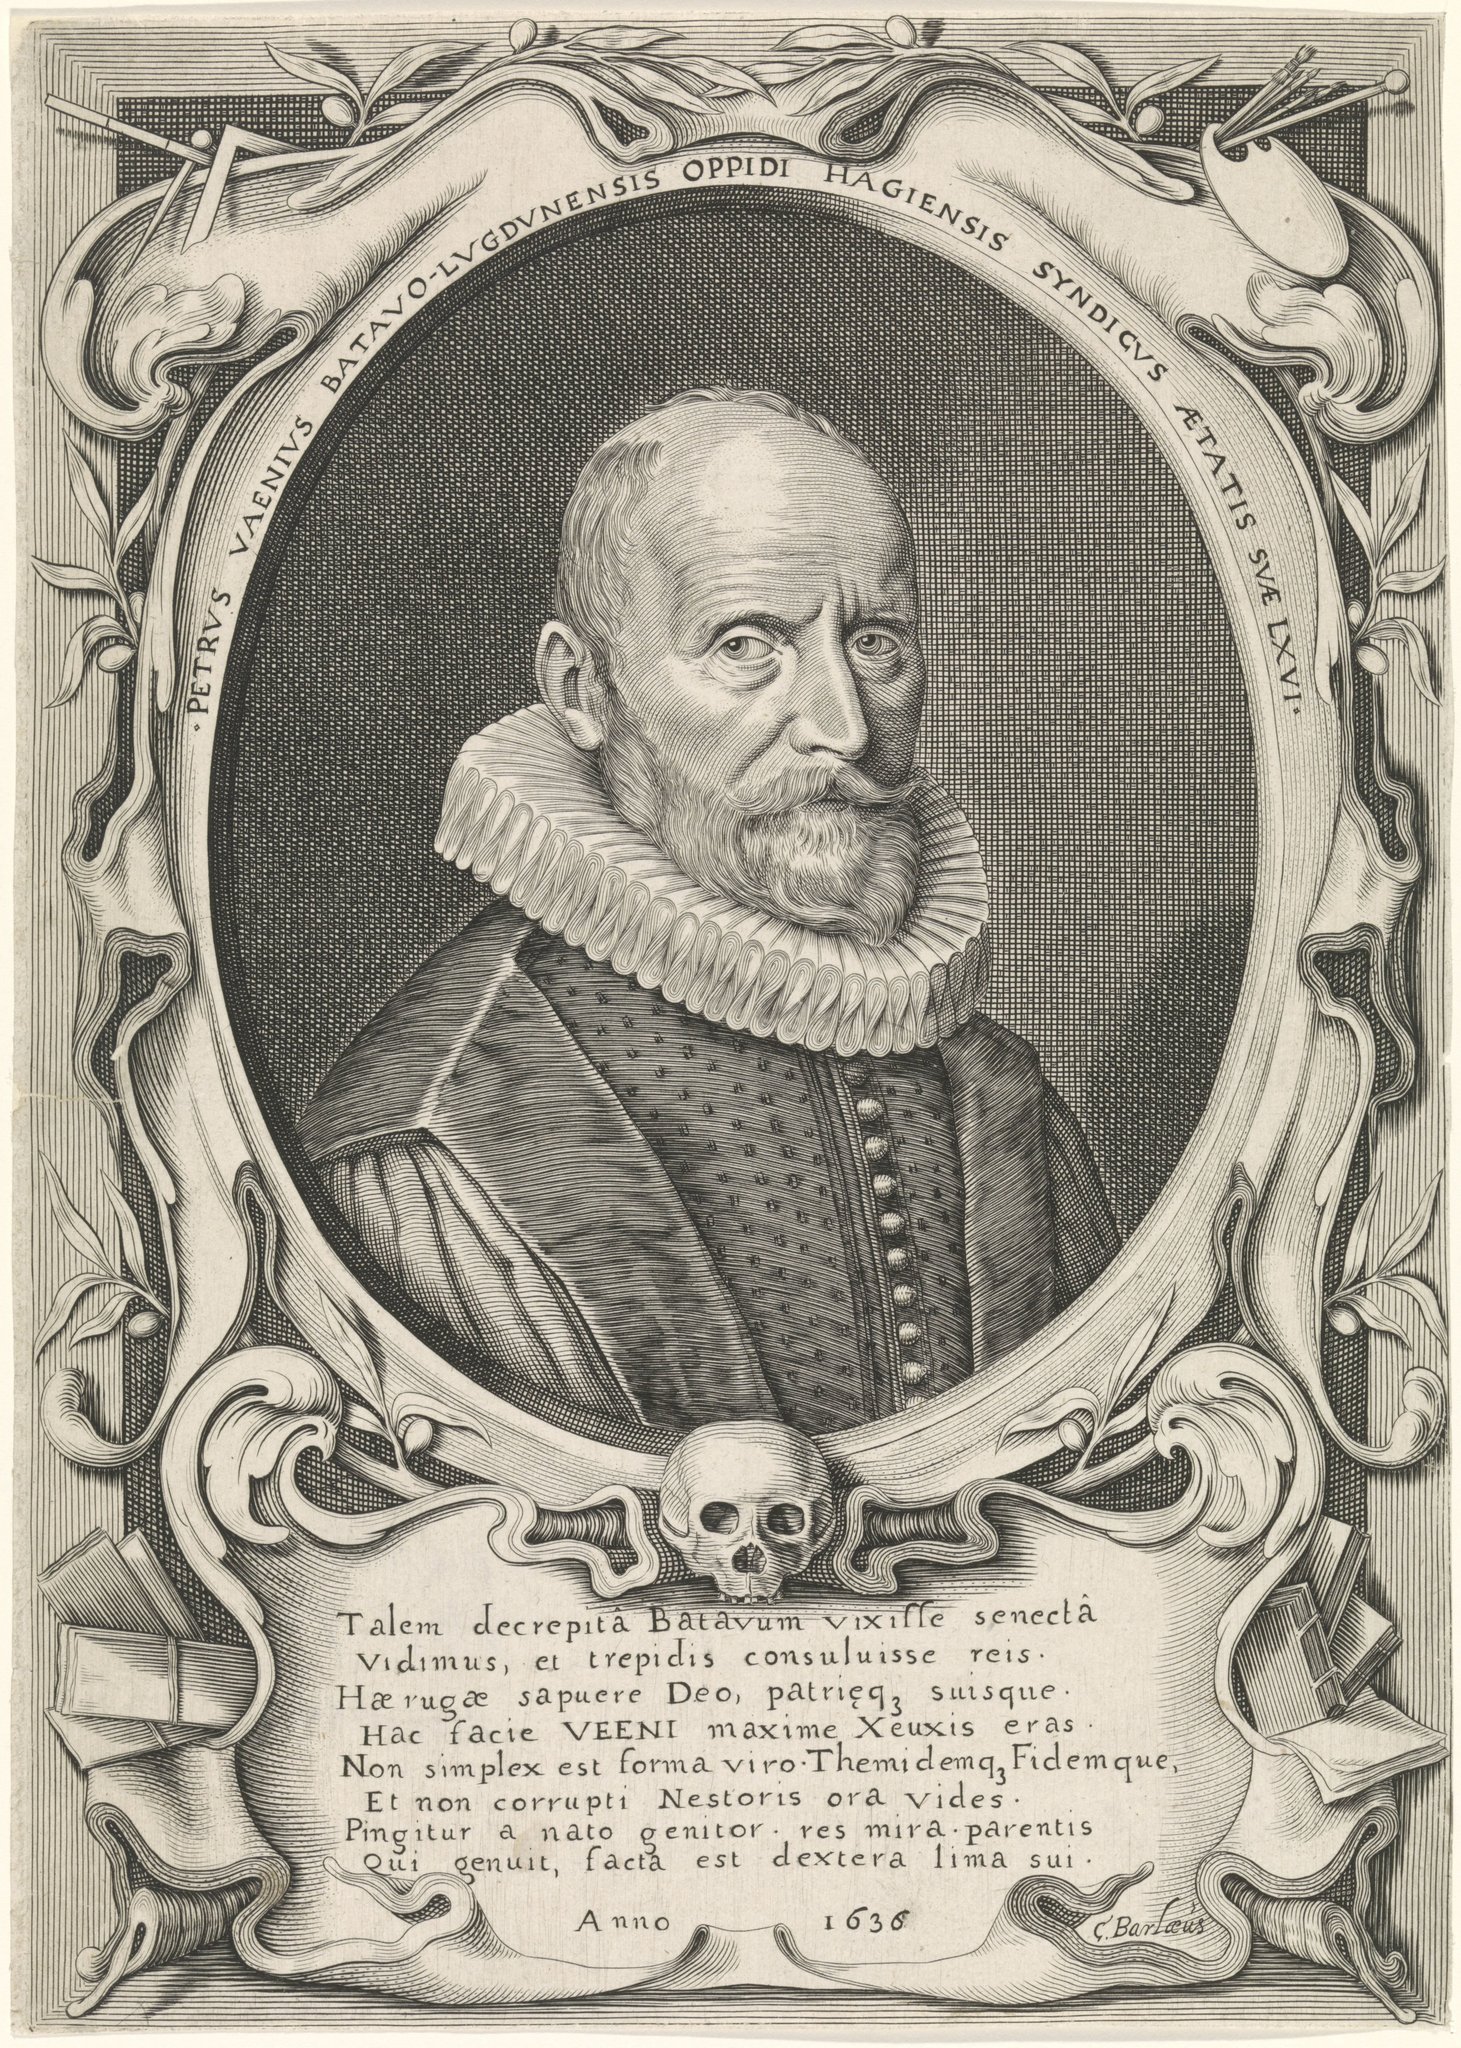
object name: print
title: Portret van Pieter van Veen (I), tekenaar en schilder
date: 1636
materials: paper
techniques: engraving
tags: leiden, the hague, painter, draughtsman, pieter van veen (i)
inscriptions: collector's mark: Lugt 240